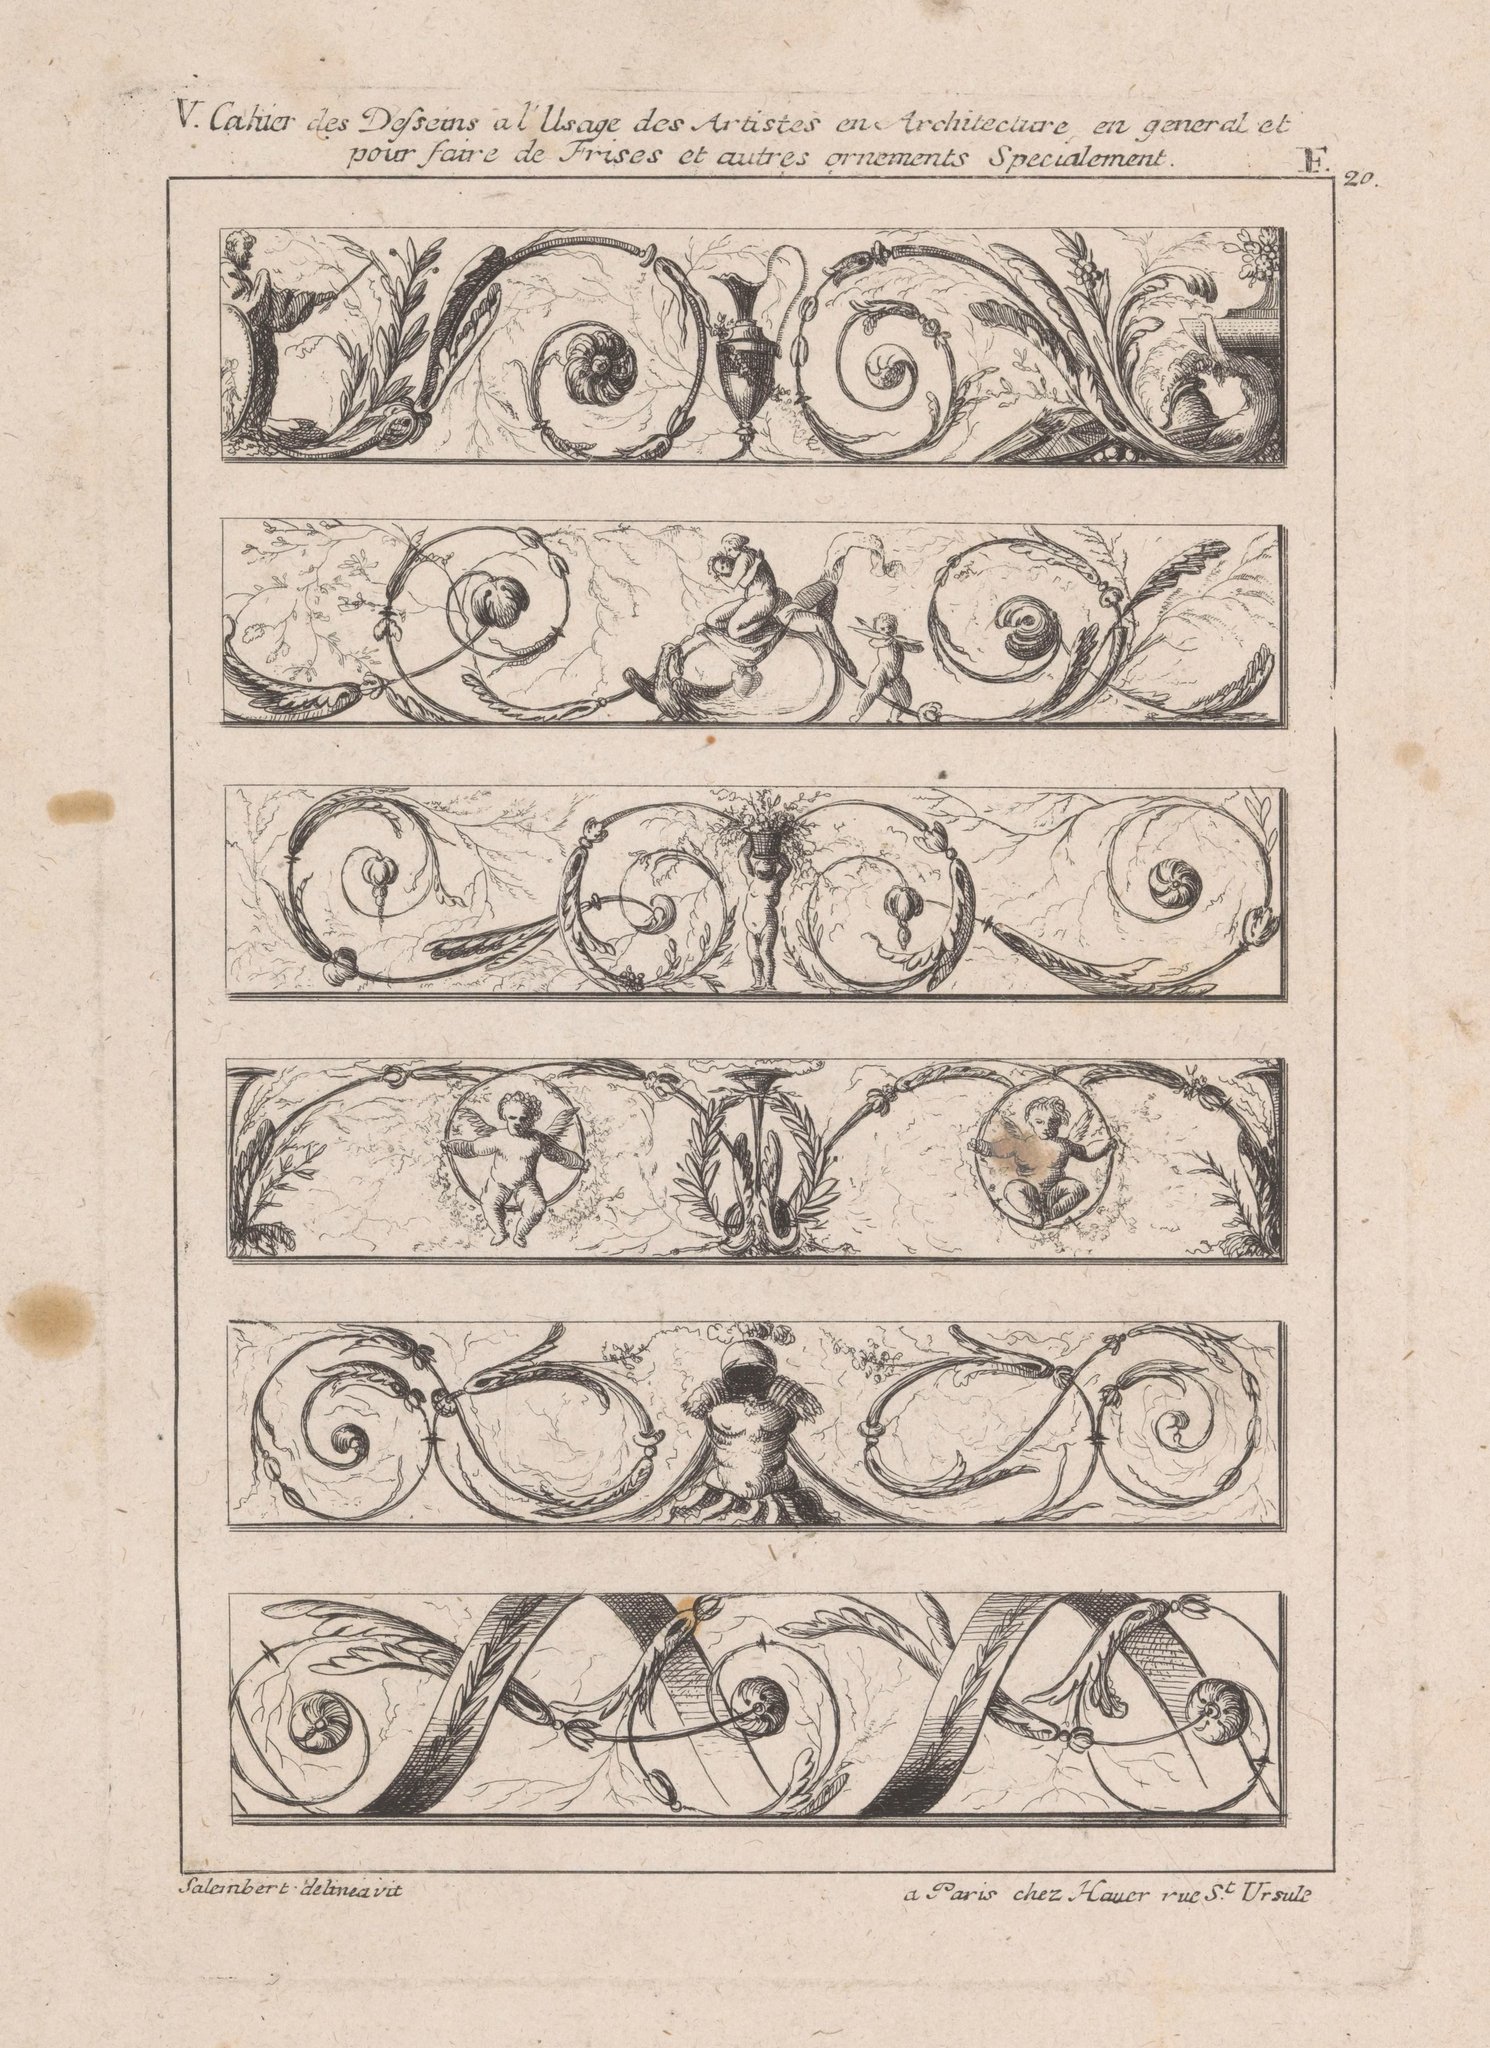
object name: print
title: Desseins de la Mode neuve au Gout antique (...)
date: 1781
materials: paper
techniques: etching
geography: paris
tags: interlace ~ ornament, other architectural details, cupids: 'amores', 'amoretti', 'putti'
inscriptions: collector's mark: Lugt 2228, collector's mark: Lugt 2760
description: Zes friezen met putti, vlechtwerk en een harnas.